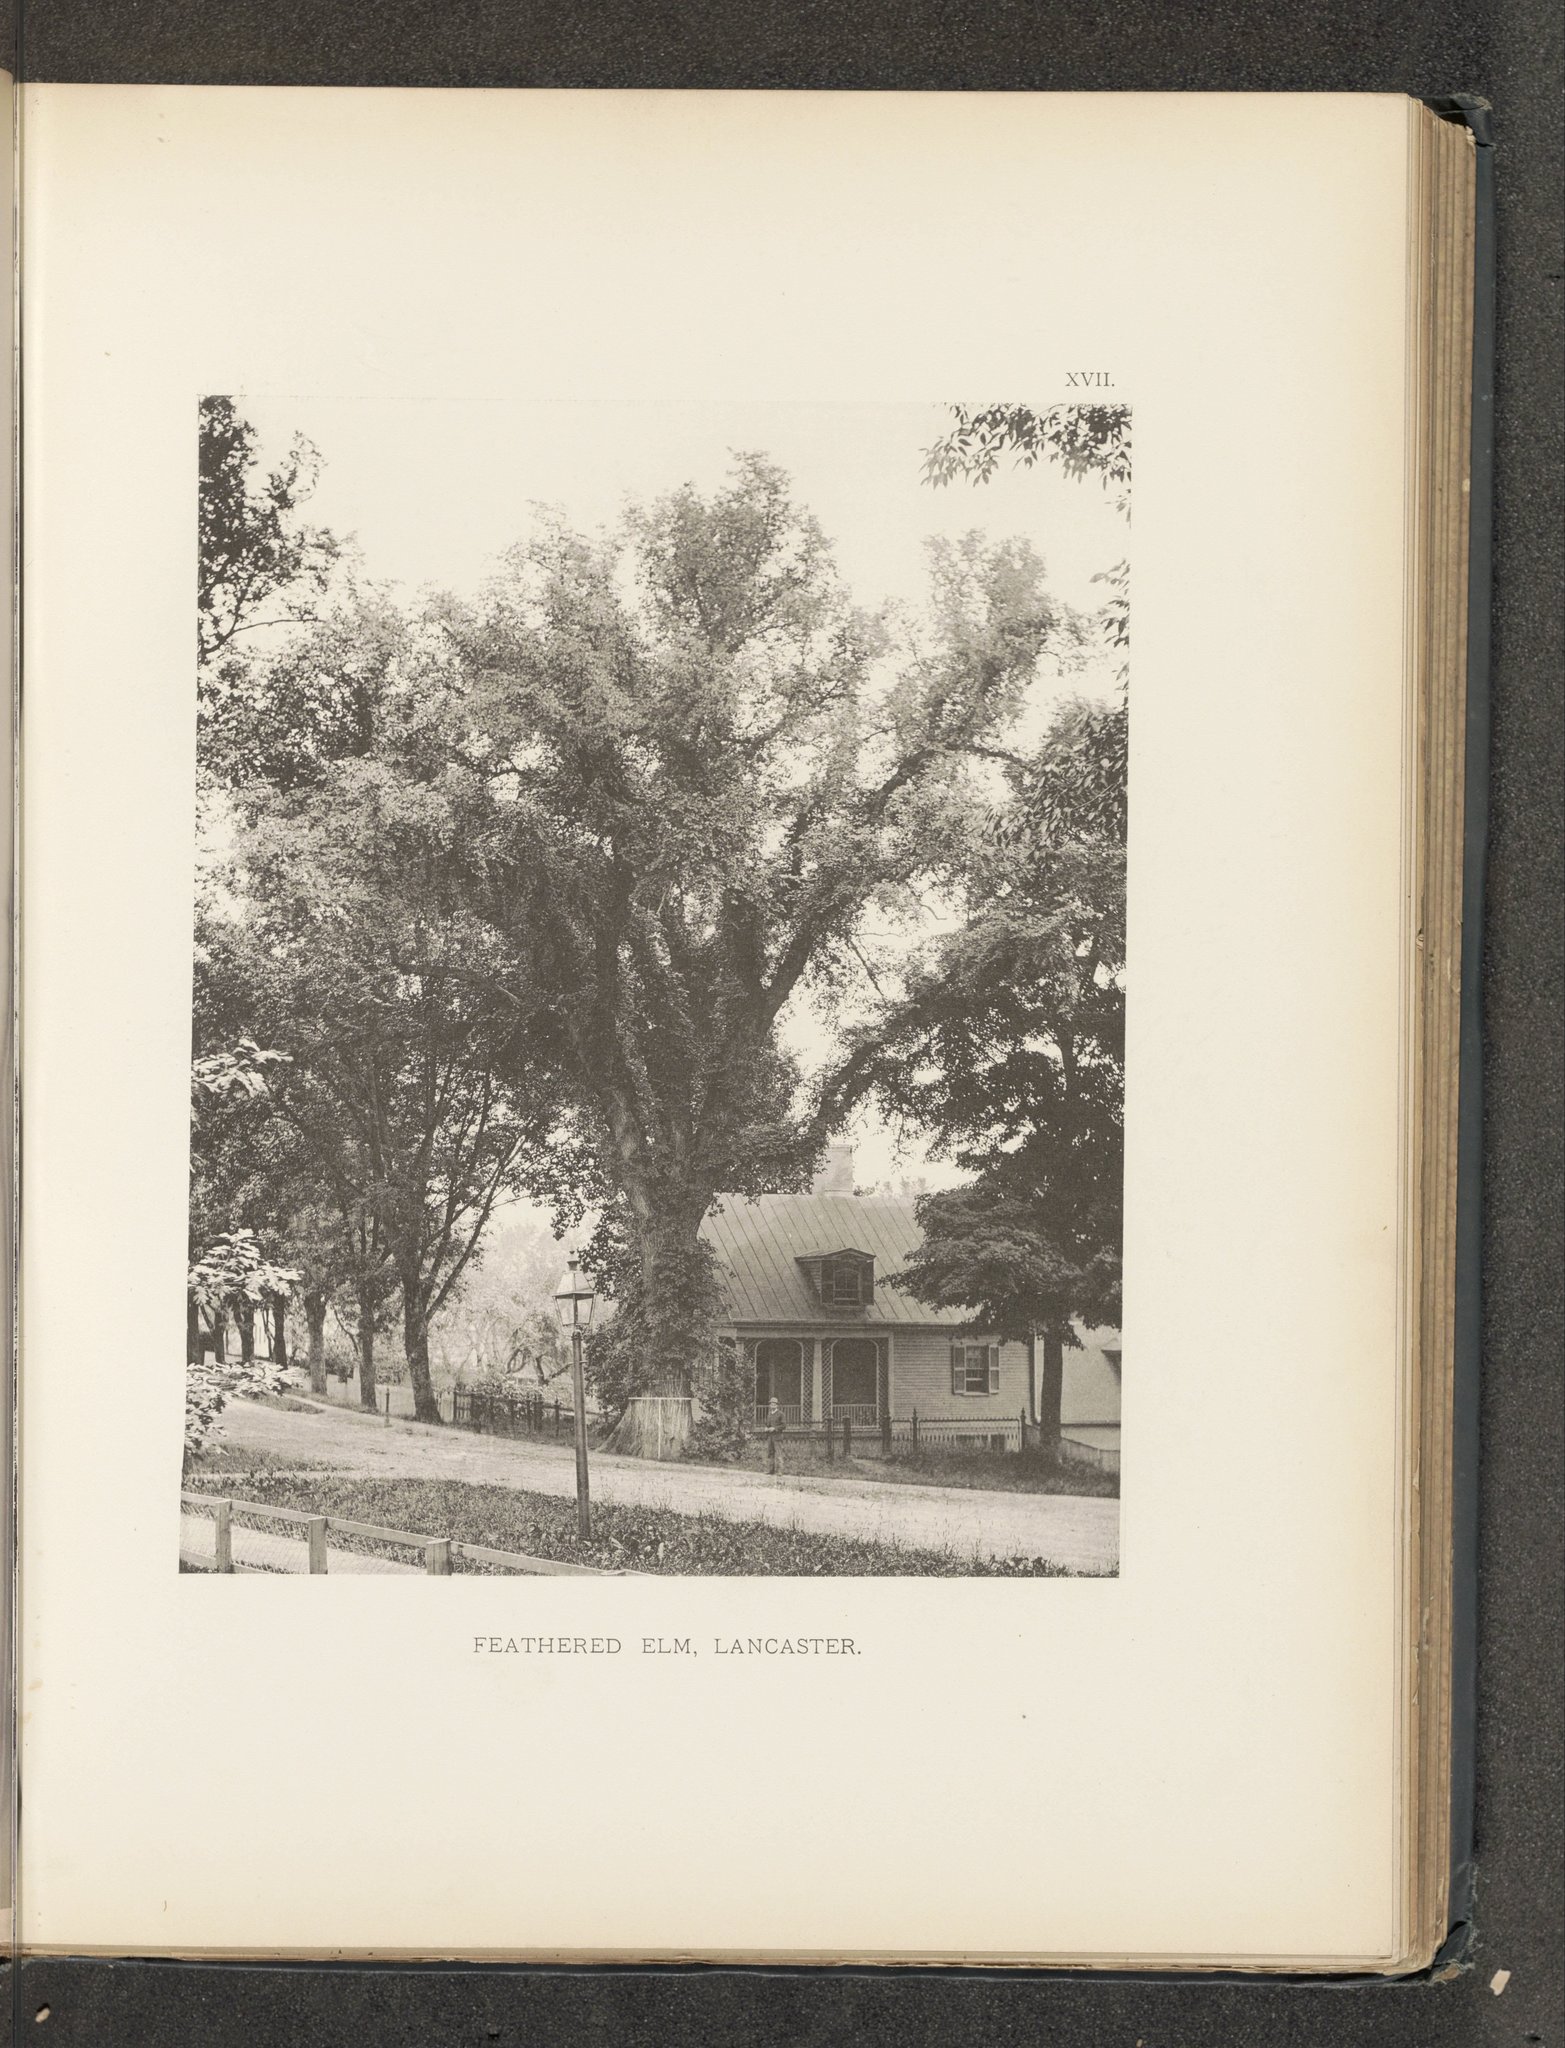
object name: page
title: Feathered elm, Lancaster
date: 1880-1890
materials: paper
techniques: photograph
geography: lancaster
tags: trees: elm, façade (of house or building), public road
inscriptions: number: ‘XVII.’